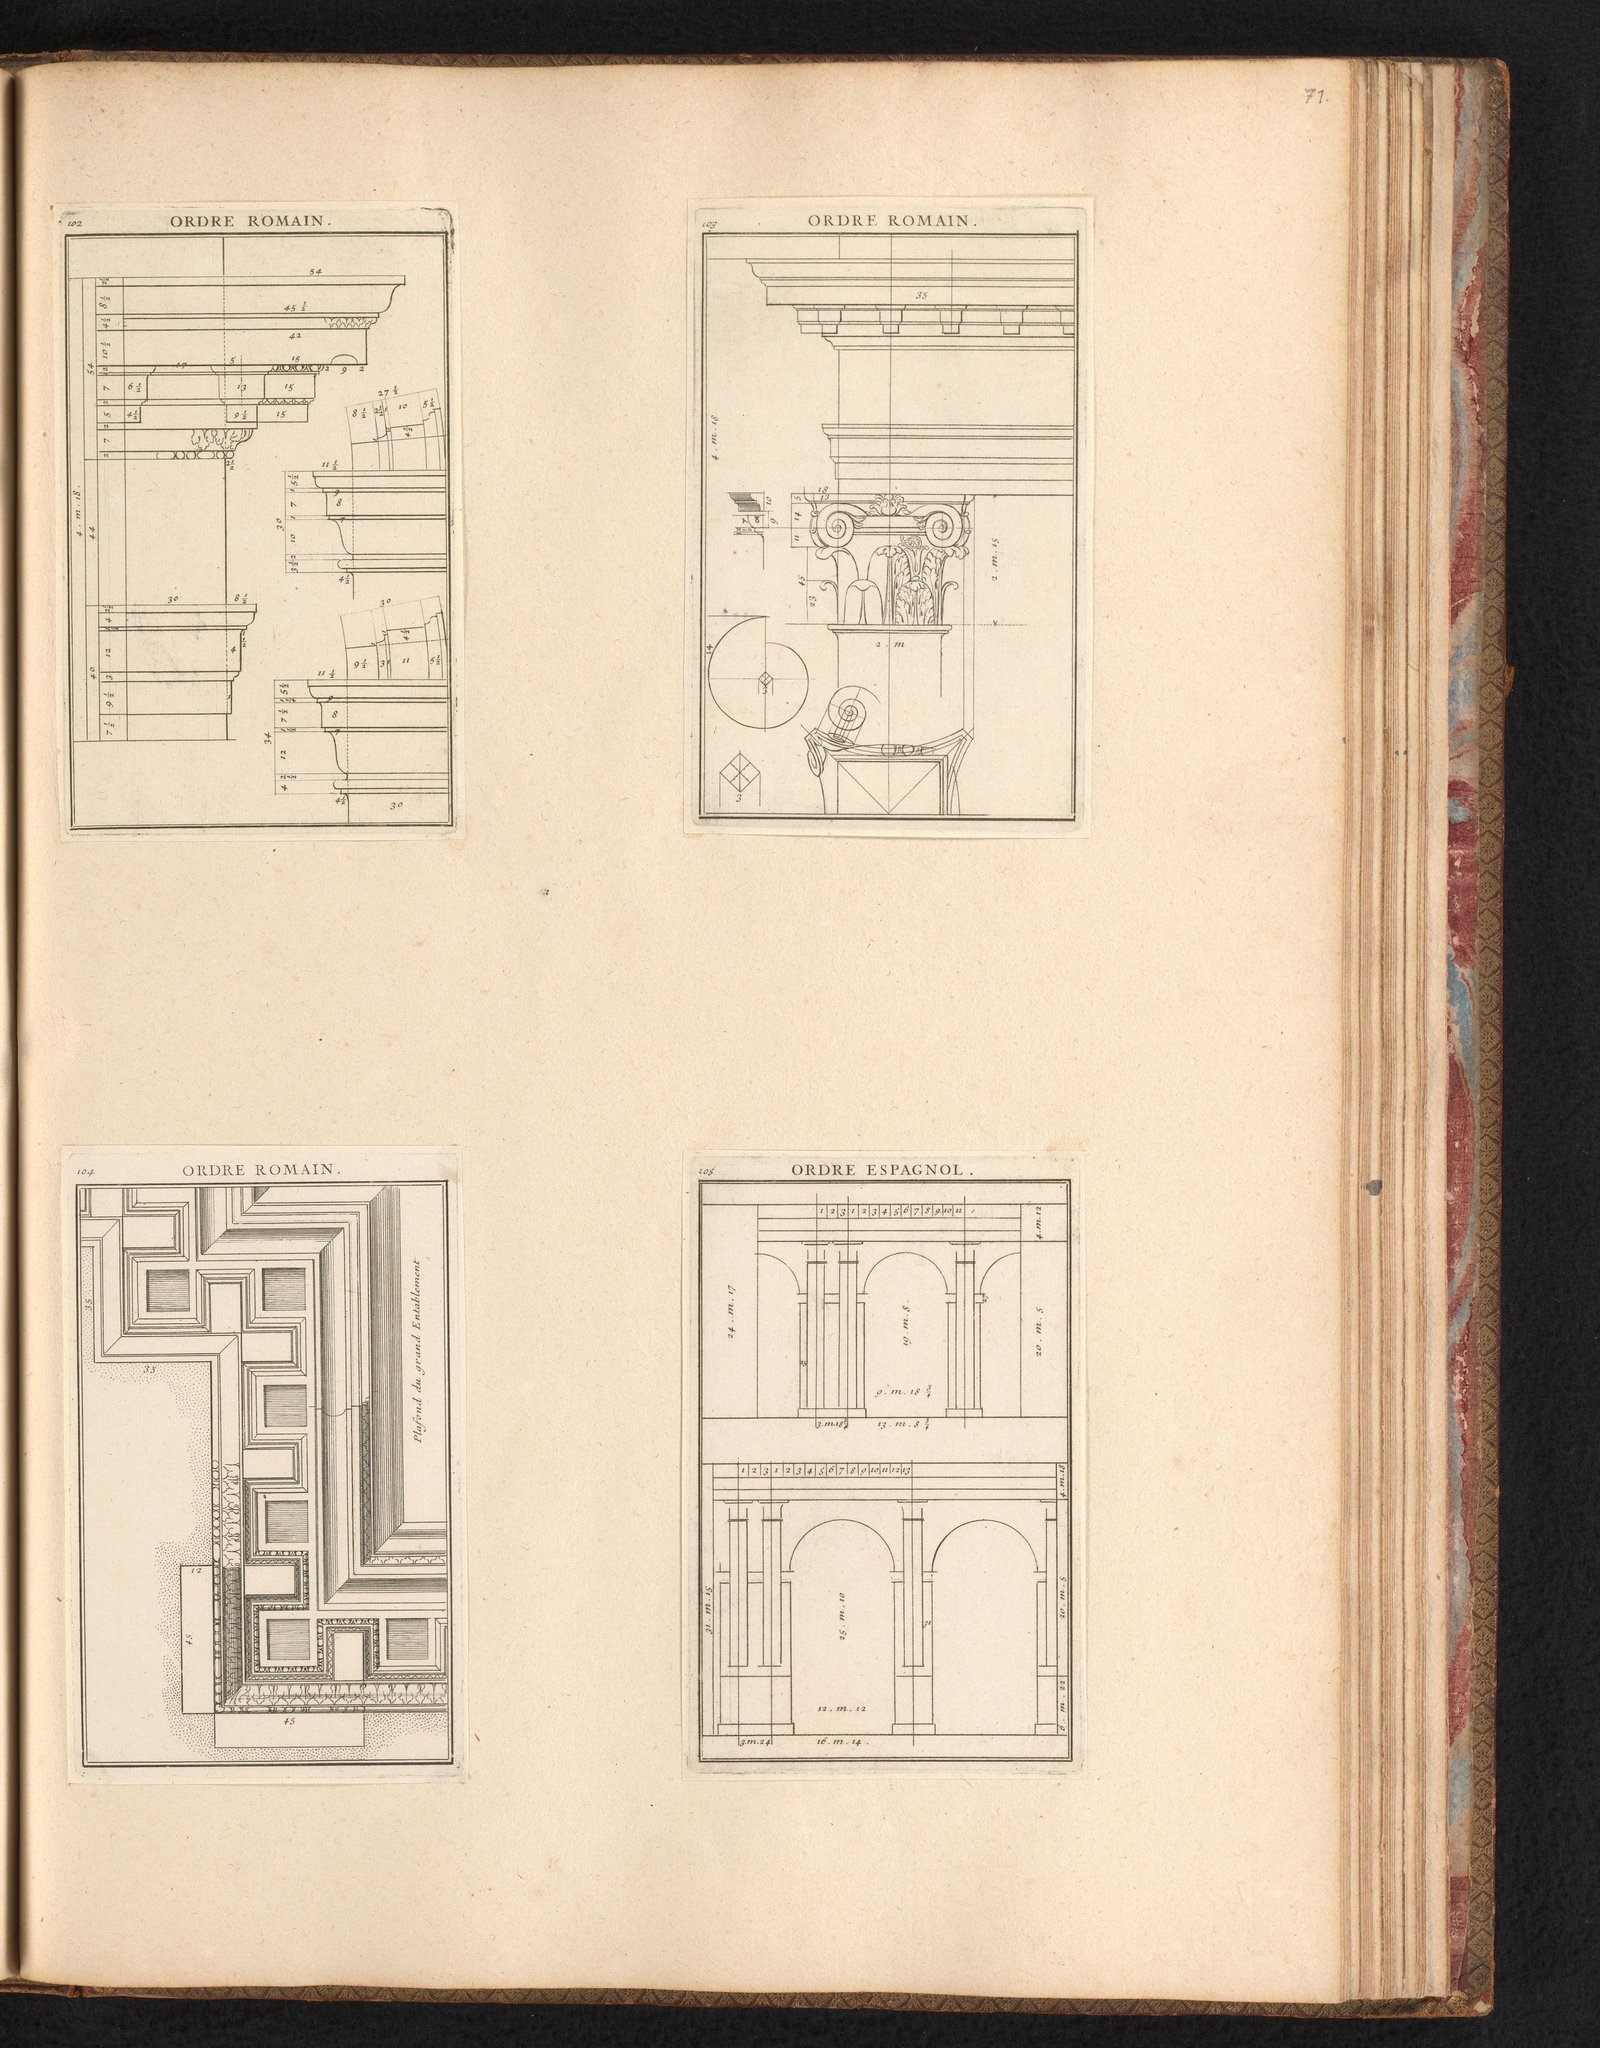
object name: album leaf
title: Pilasters van de Composiete en Spaanse orde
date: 1714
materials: paper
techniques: etching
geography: paris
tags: composite order ~ architecture, orders, order-books ~ architecture, half-column, pilaster ~ architecture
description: Prenten uit: Leclerc, Sébastien (I). Traité d'architecture. Parijs: Pierre François Giffart, 1714.